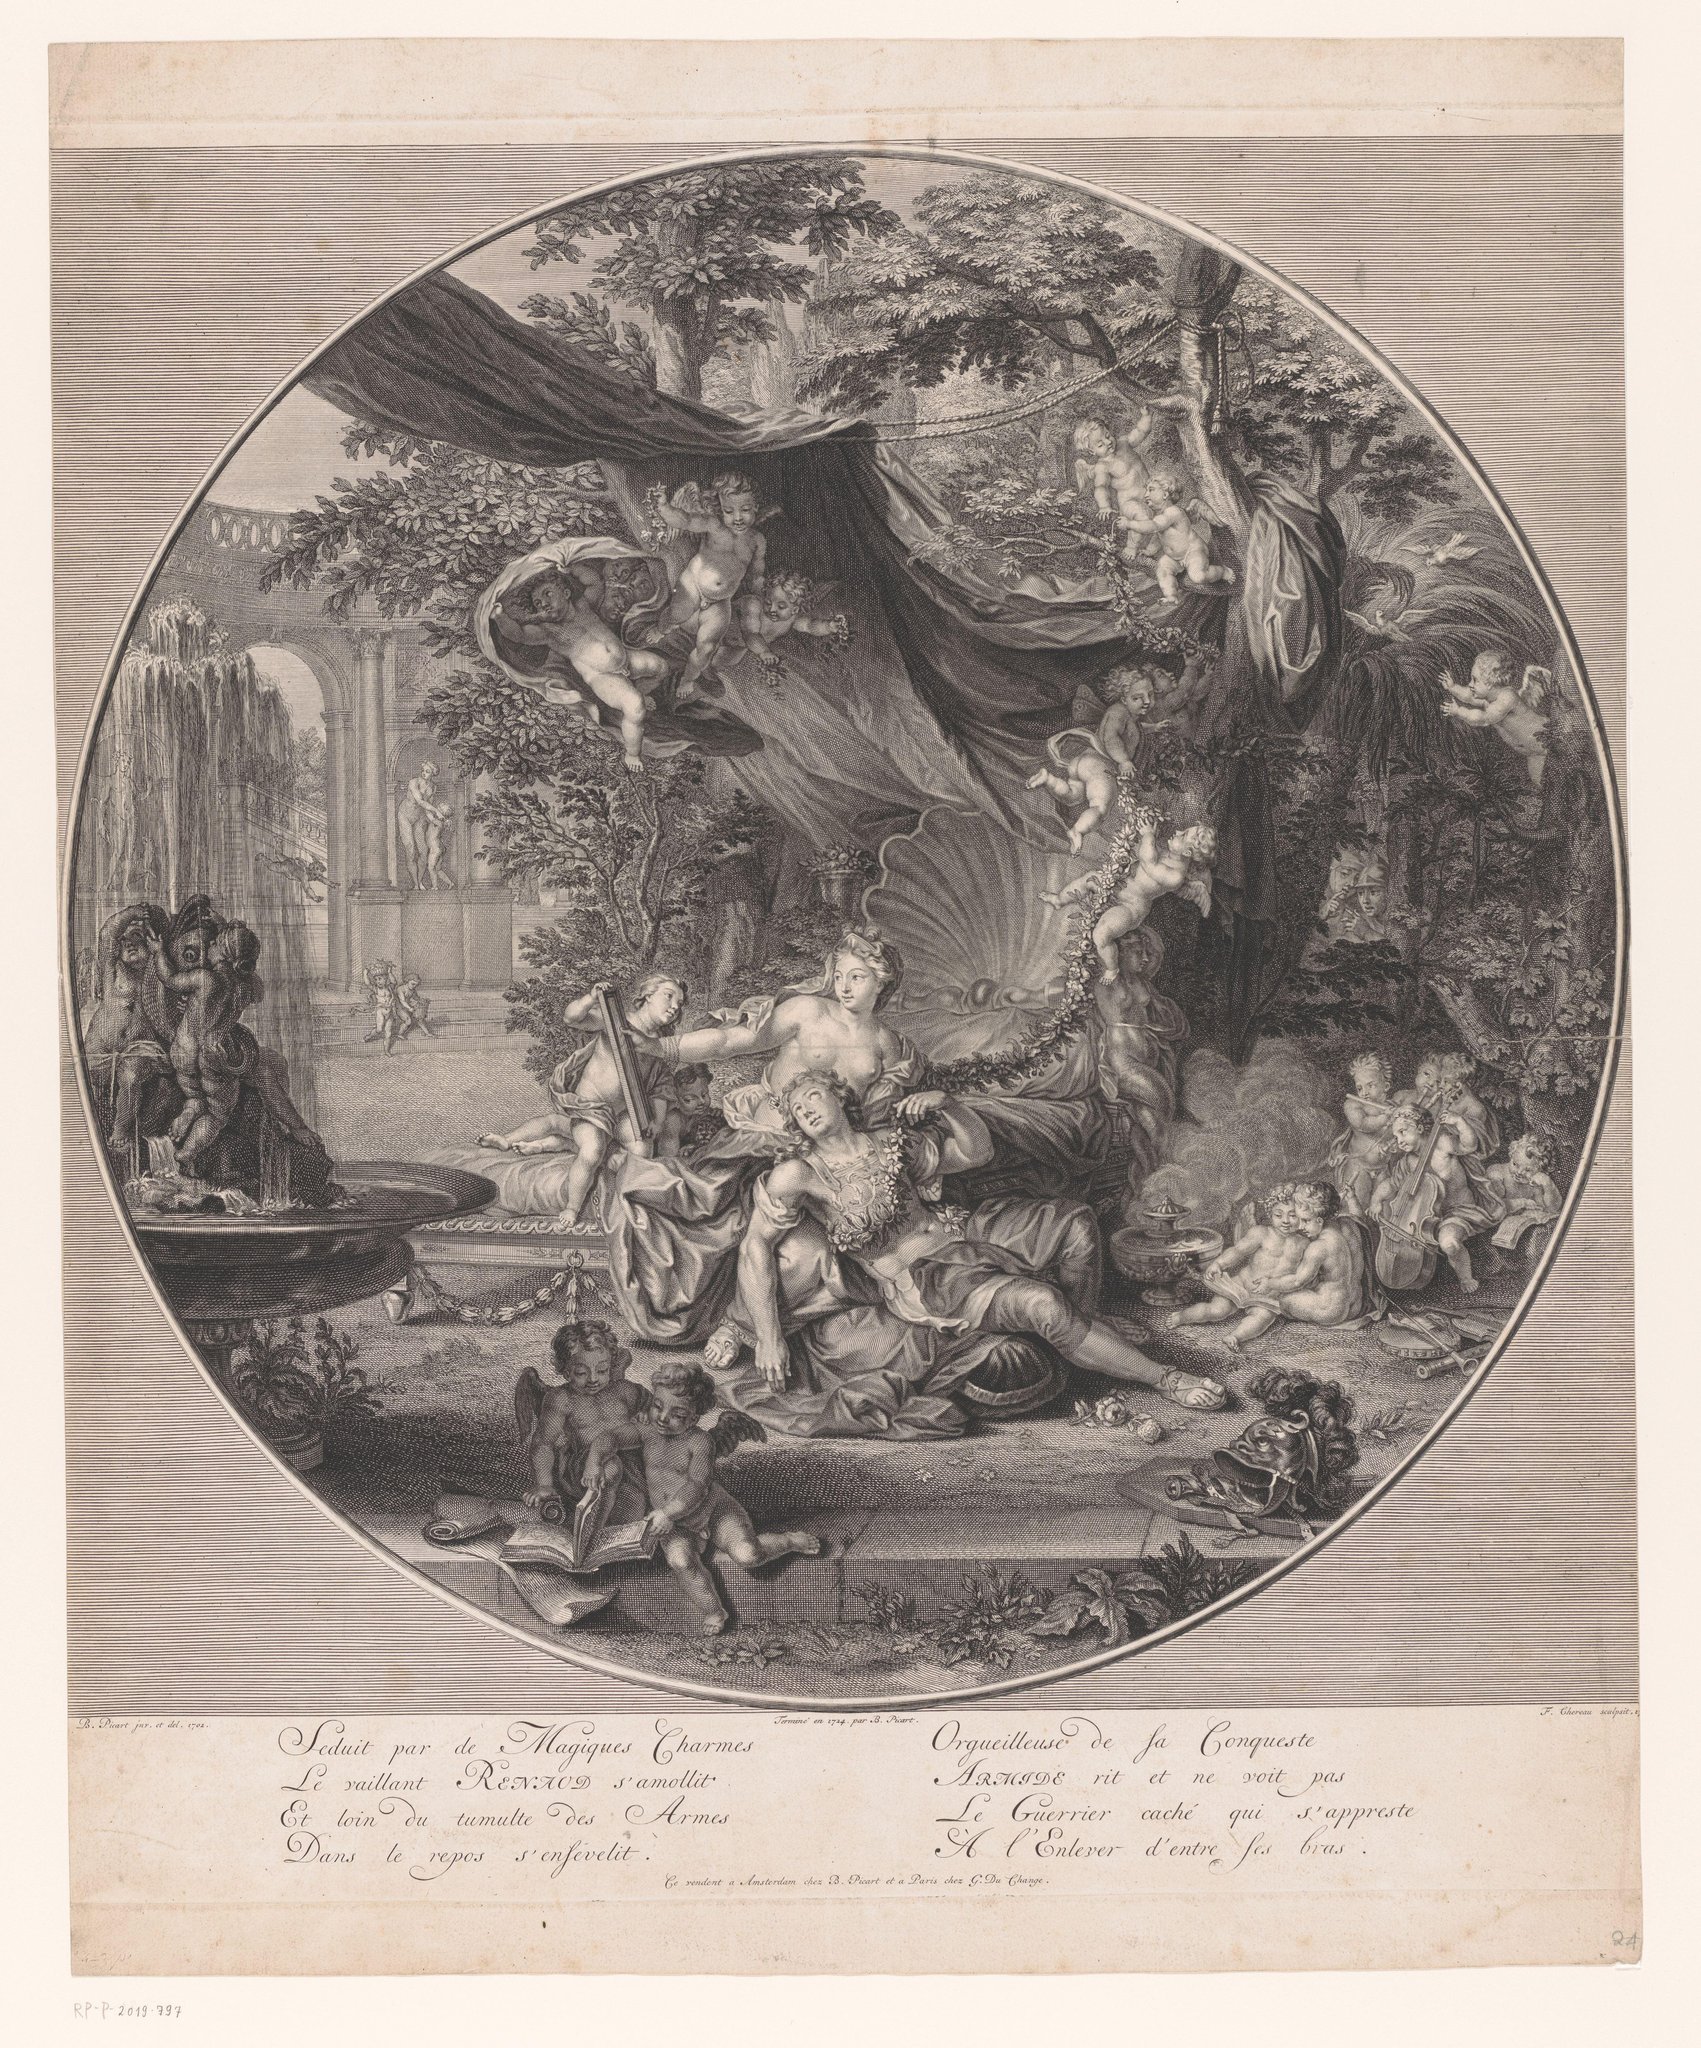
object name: print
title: Rinaldo en Armida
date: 1724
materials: paper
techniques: engraving, etching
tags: rinaldo, armida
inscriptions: collector's mark: Lugt 2228